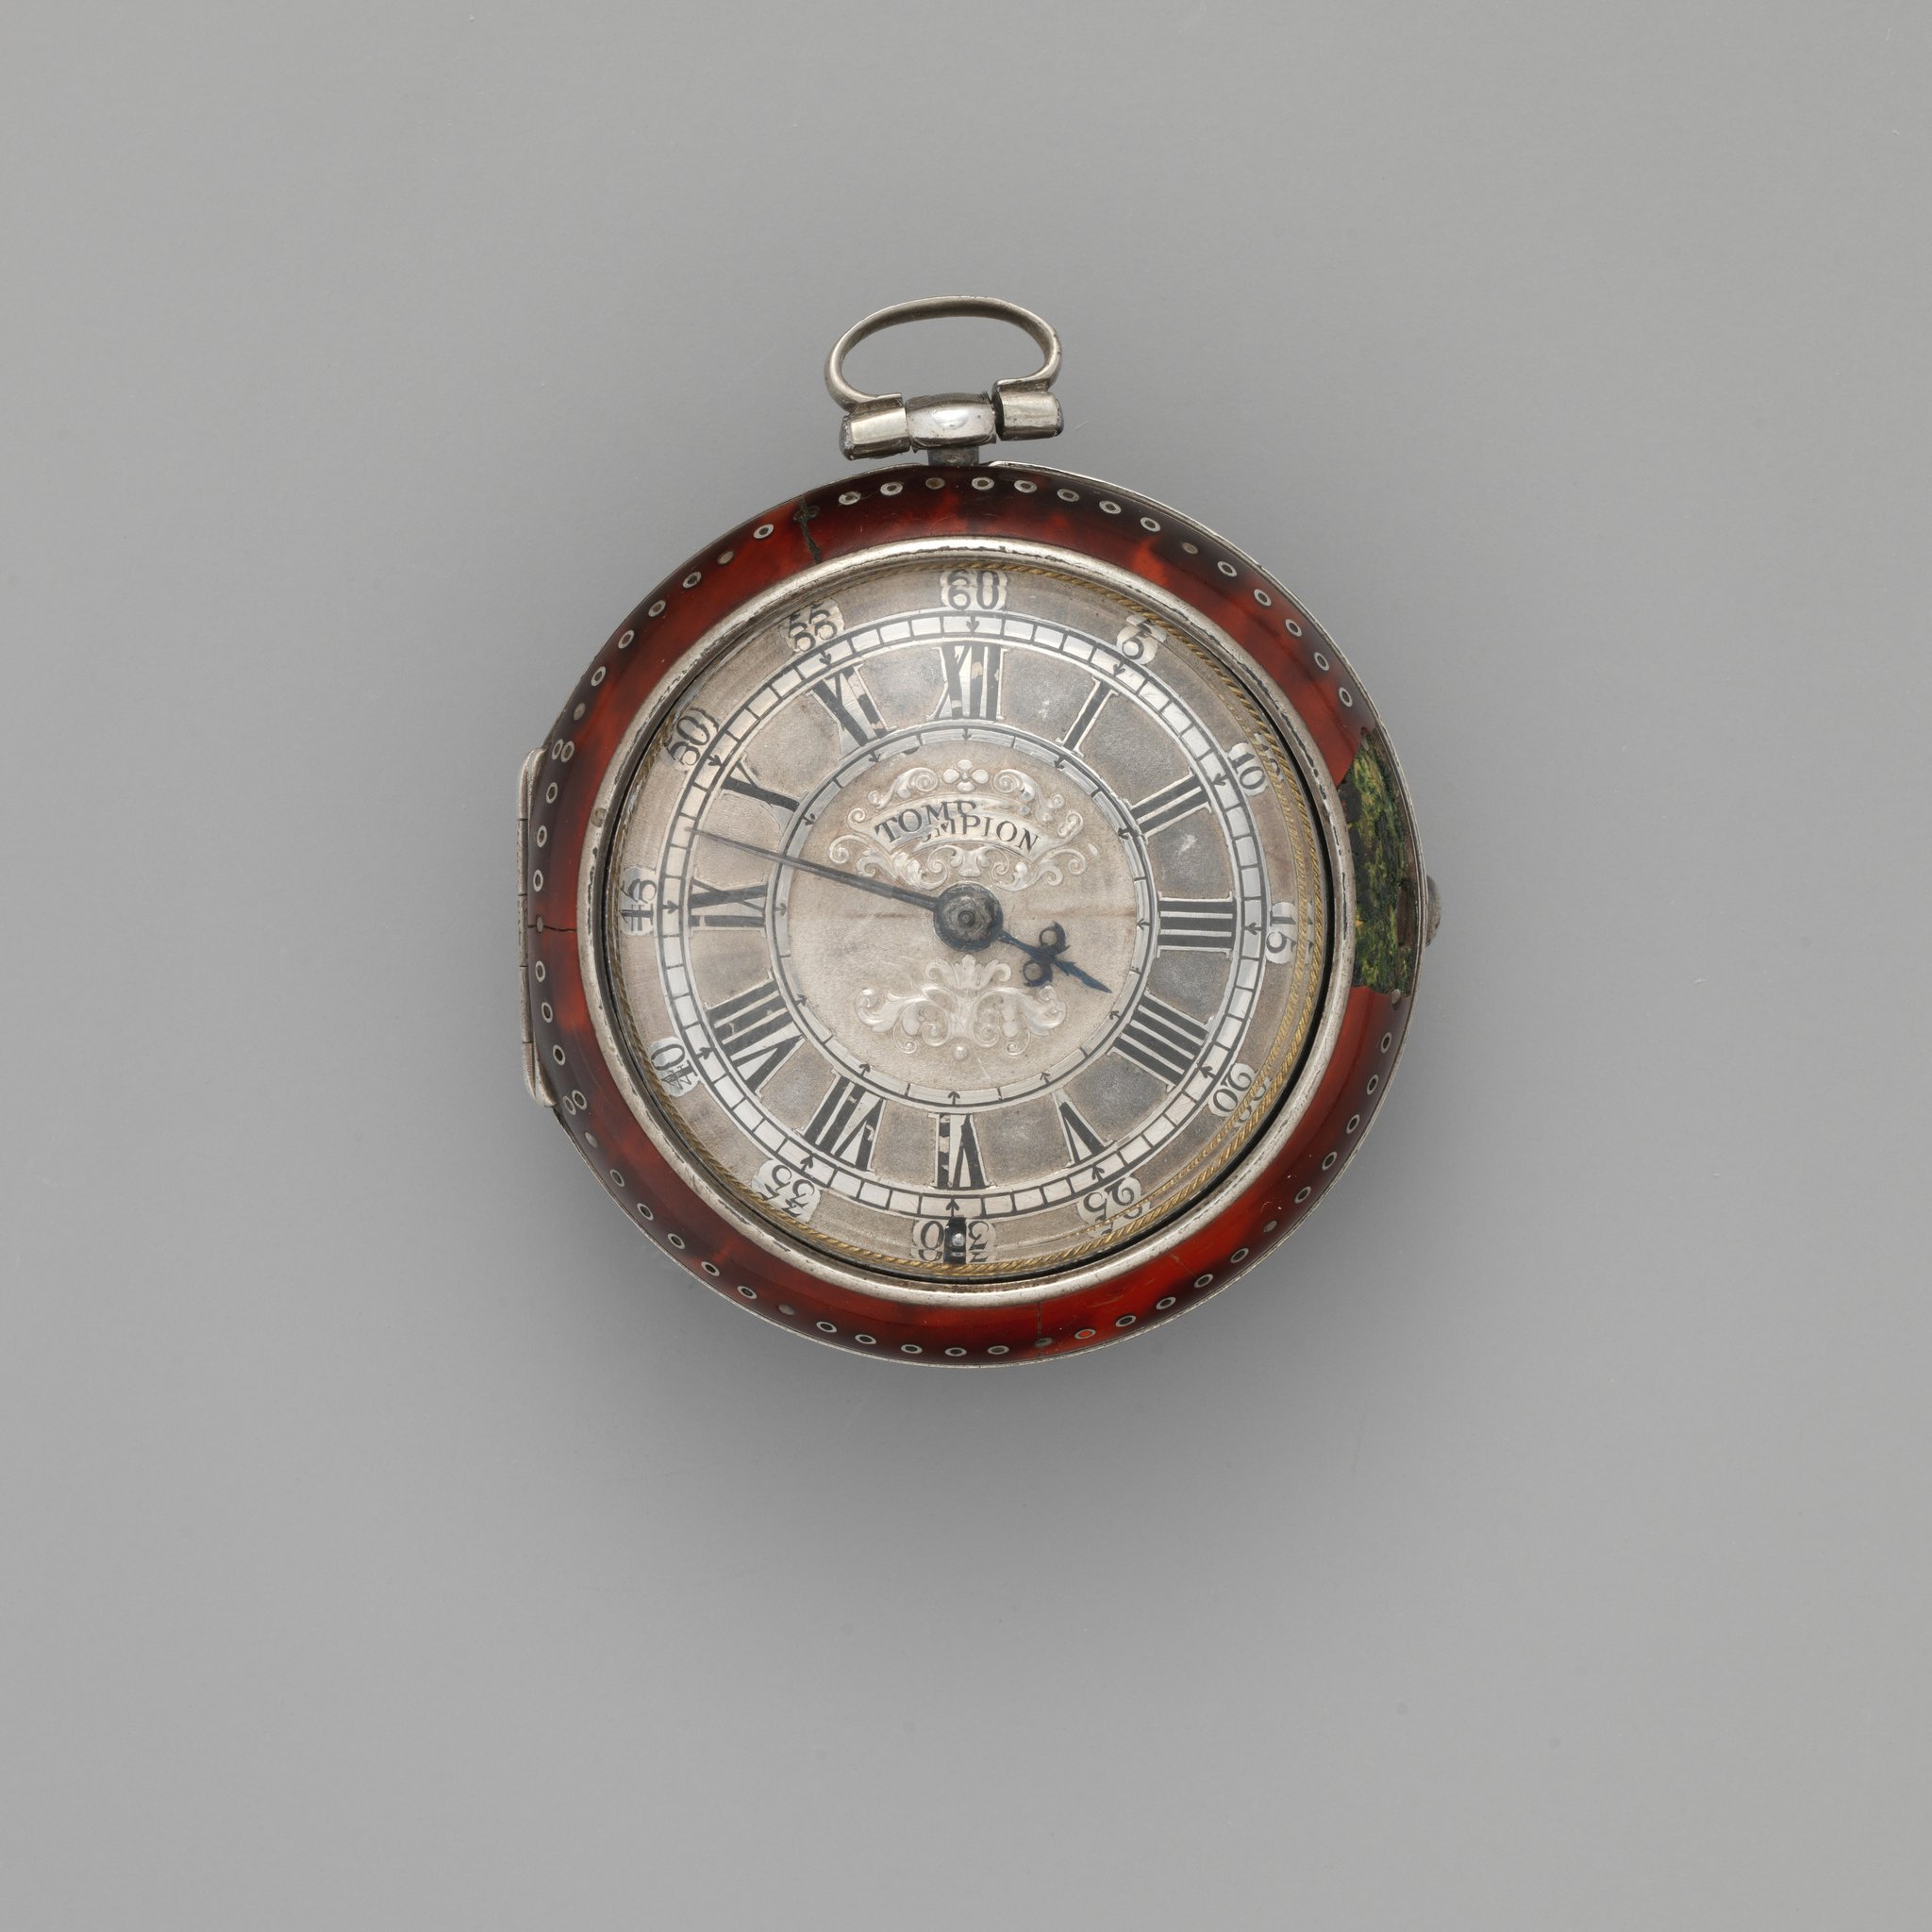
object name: pair case watch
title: Pair-case watch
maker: thomas tompion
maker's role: maker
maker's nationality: british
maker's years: 1639-1713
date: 1685-1686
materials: silver, shell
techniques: enamel, inlay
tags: faces